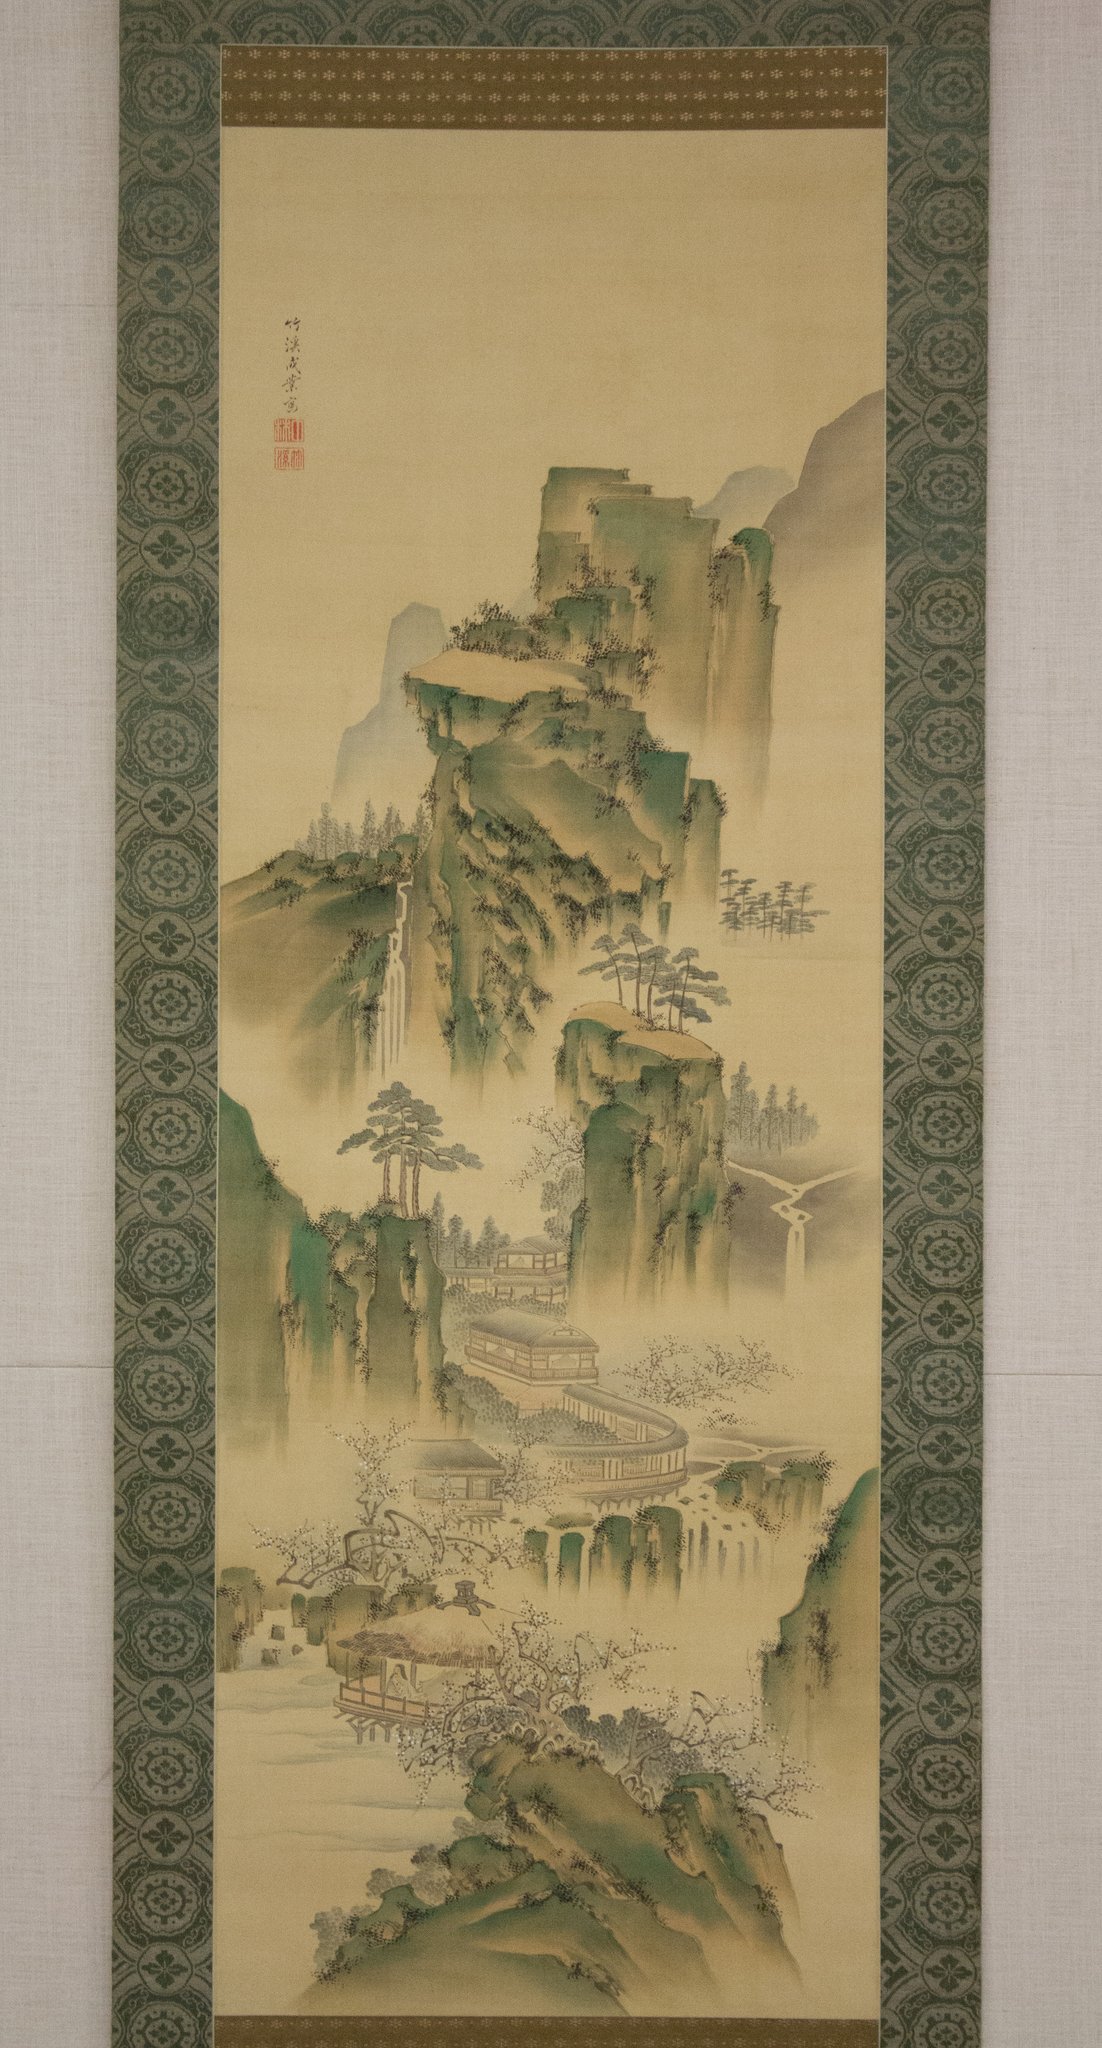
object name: hanging scroll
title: Landscape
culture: japanese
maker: nakabayashi chikkei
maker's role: artist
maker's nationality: japanese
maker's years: 1816-1867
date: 1801-1900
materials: ink, silk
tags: mountains,landscapes